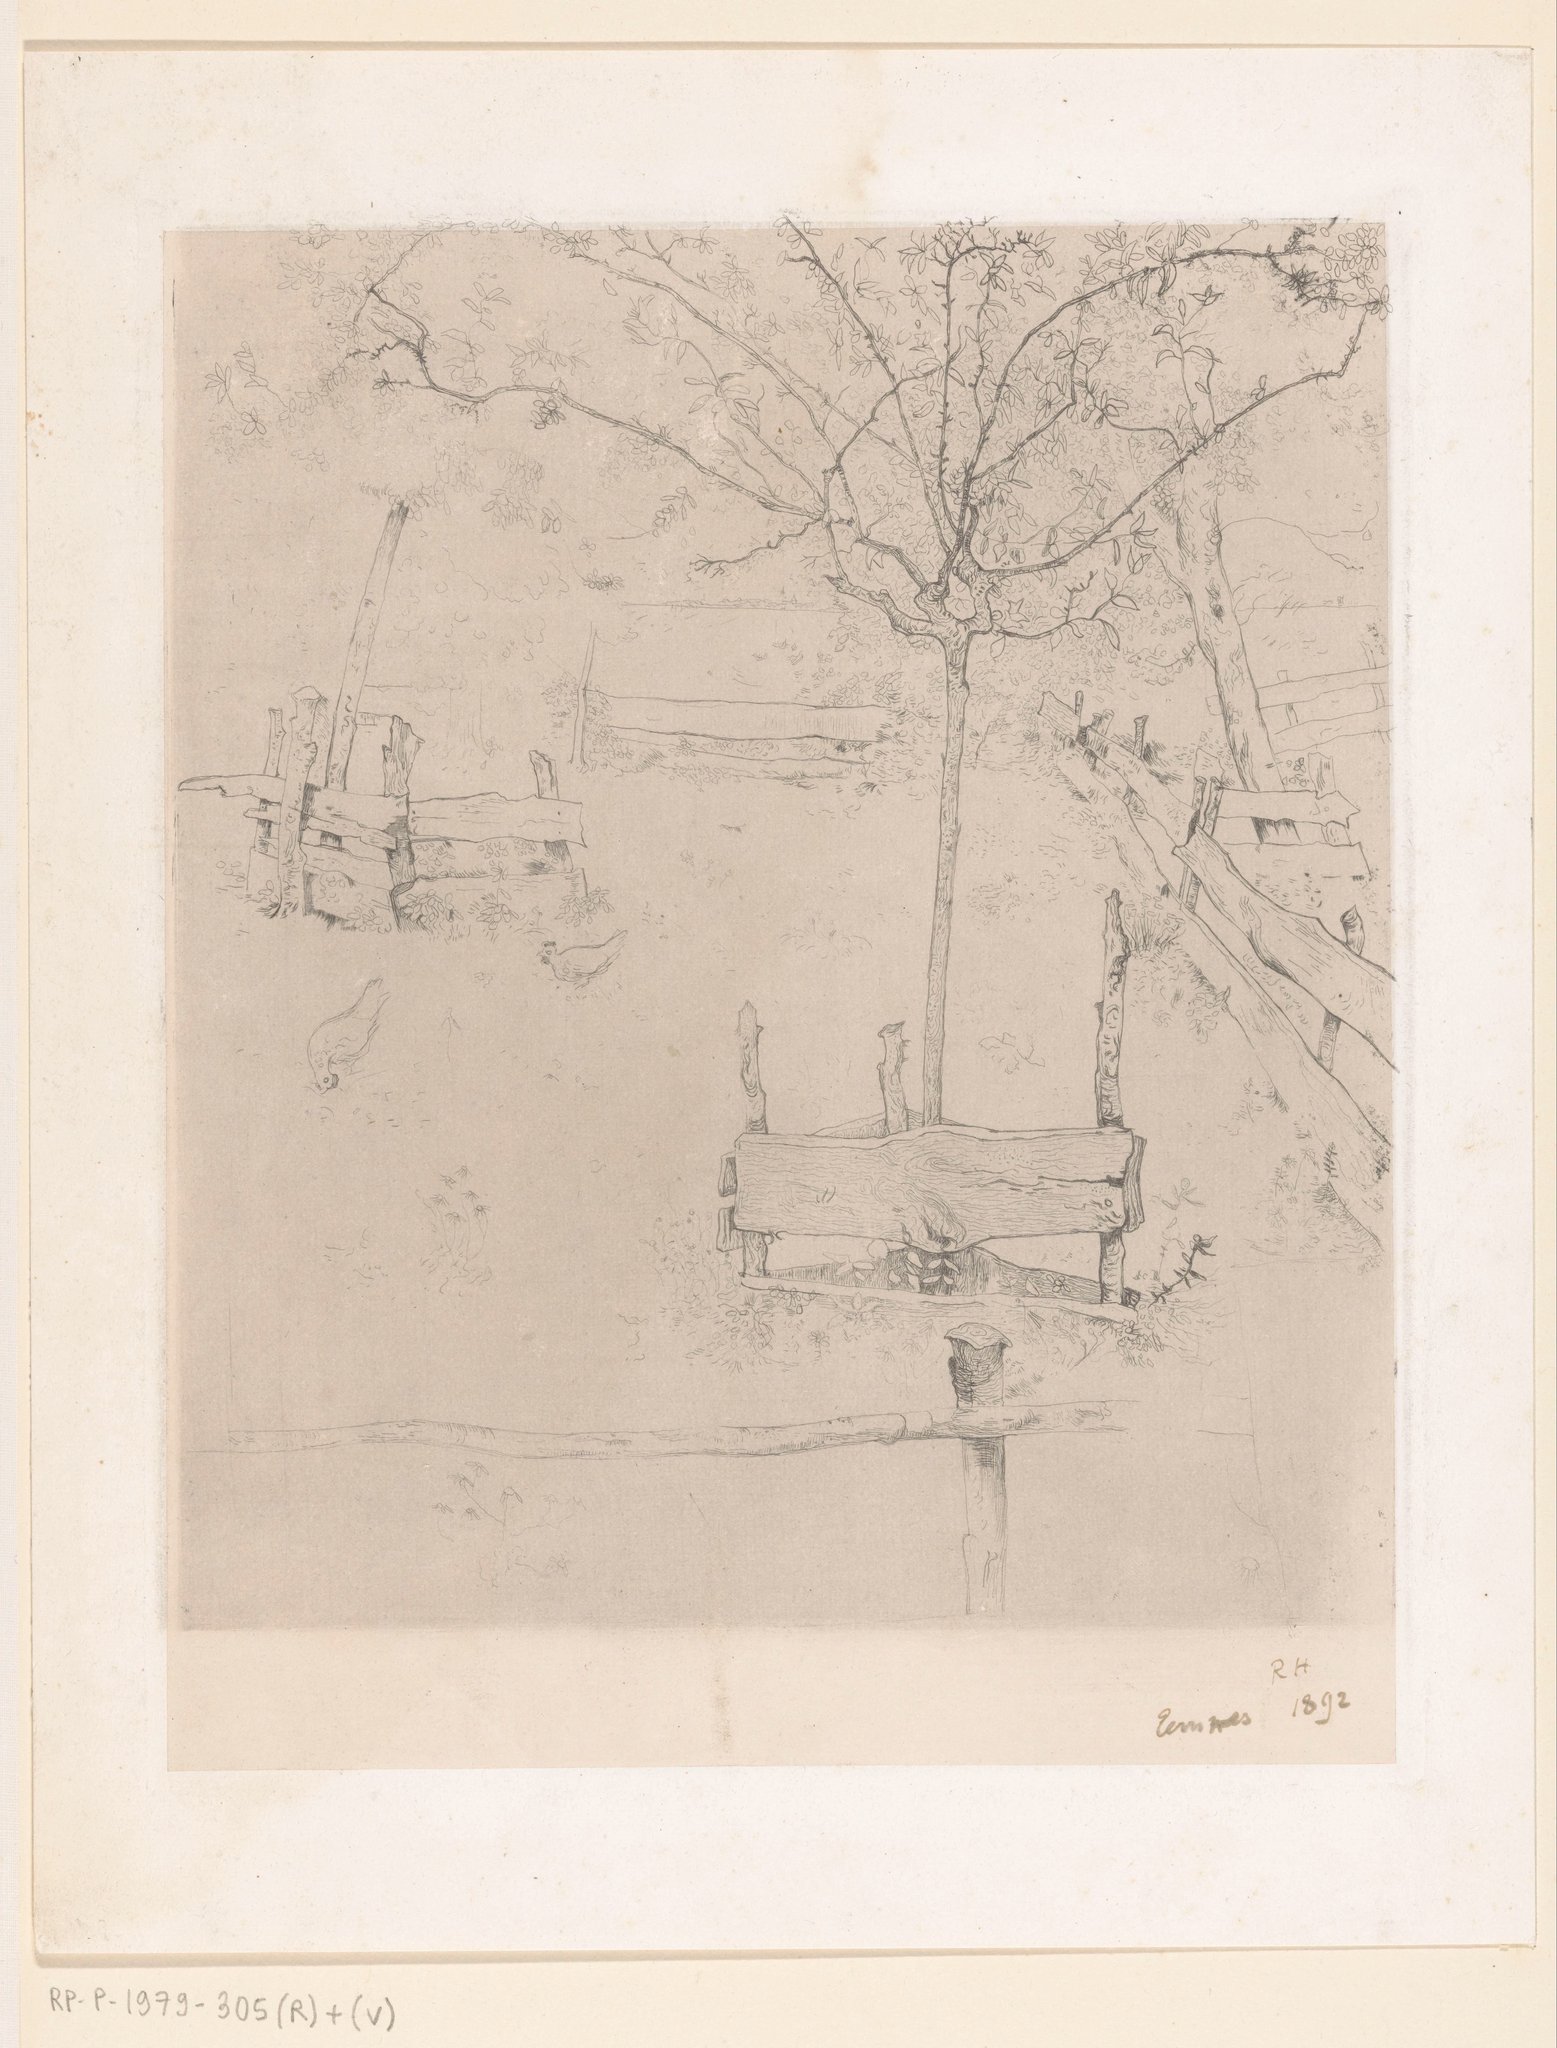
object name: print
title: Eemnes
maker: richard nicolaüs roland holst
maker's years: 1868-1938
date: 1892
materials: paper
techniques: etching, intaglio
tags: orchard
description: Een met hekken begrensd veld met daarin een fruitboom en twee scharrelende kippen.